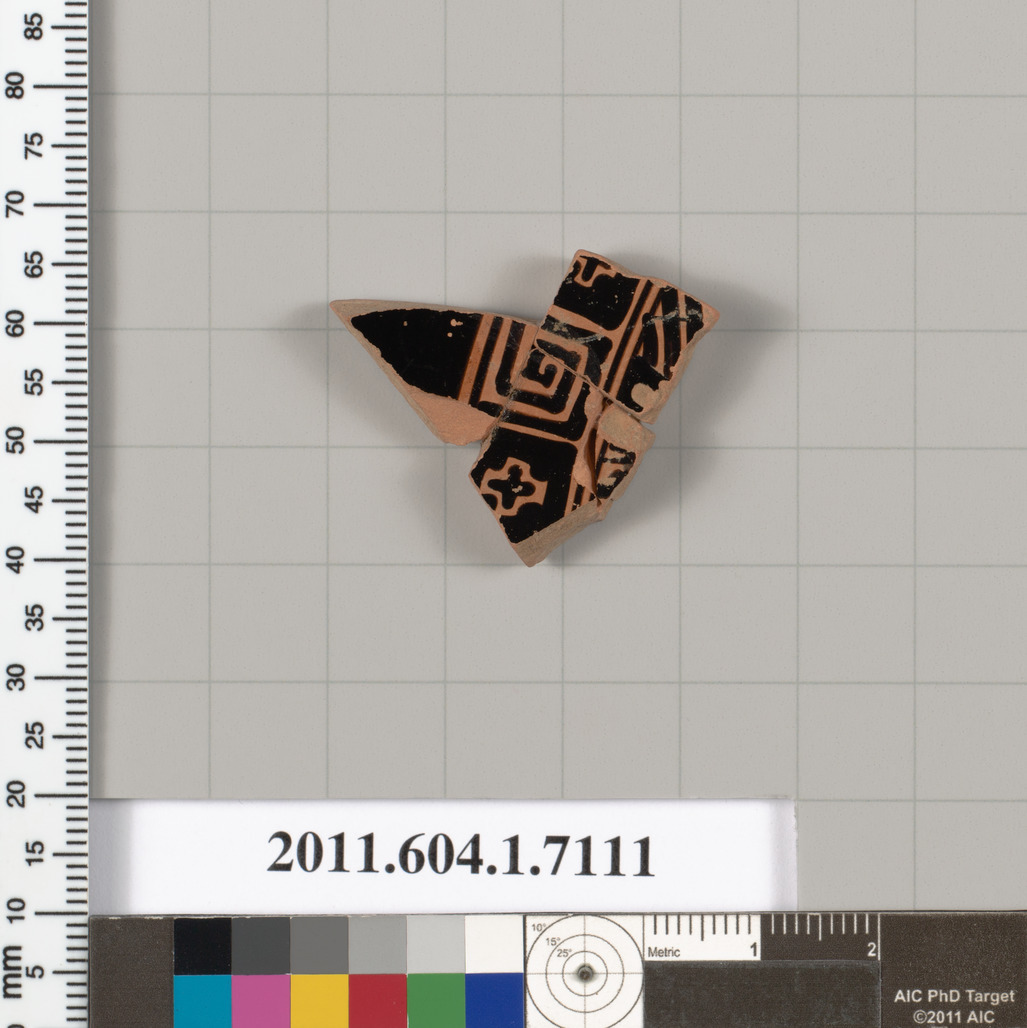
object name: kylix fragment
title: Terracotta fragment of a kylix (drinking cup)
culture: greek, attic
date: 500-480 BCE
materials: terracotta